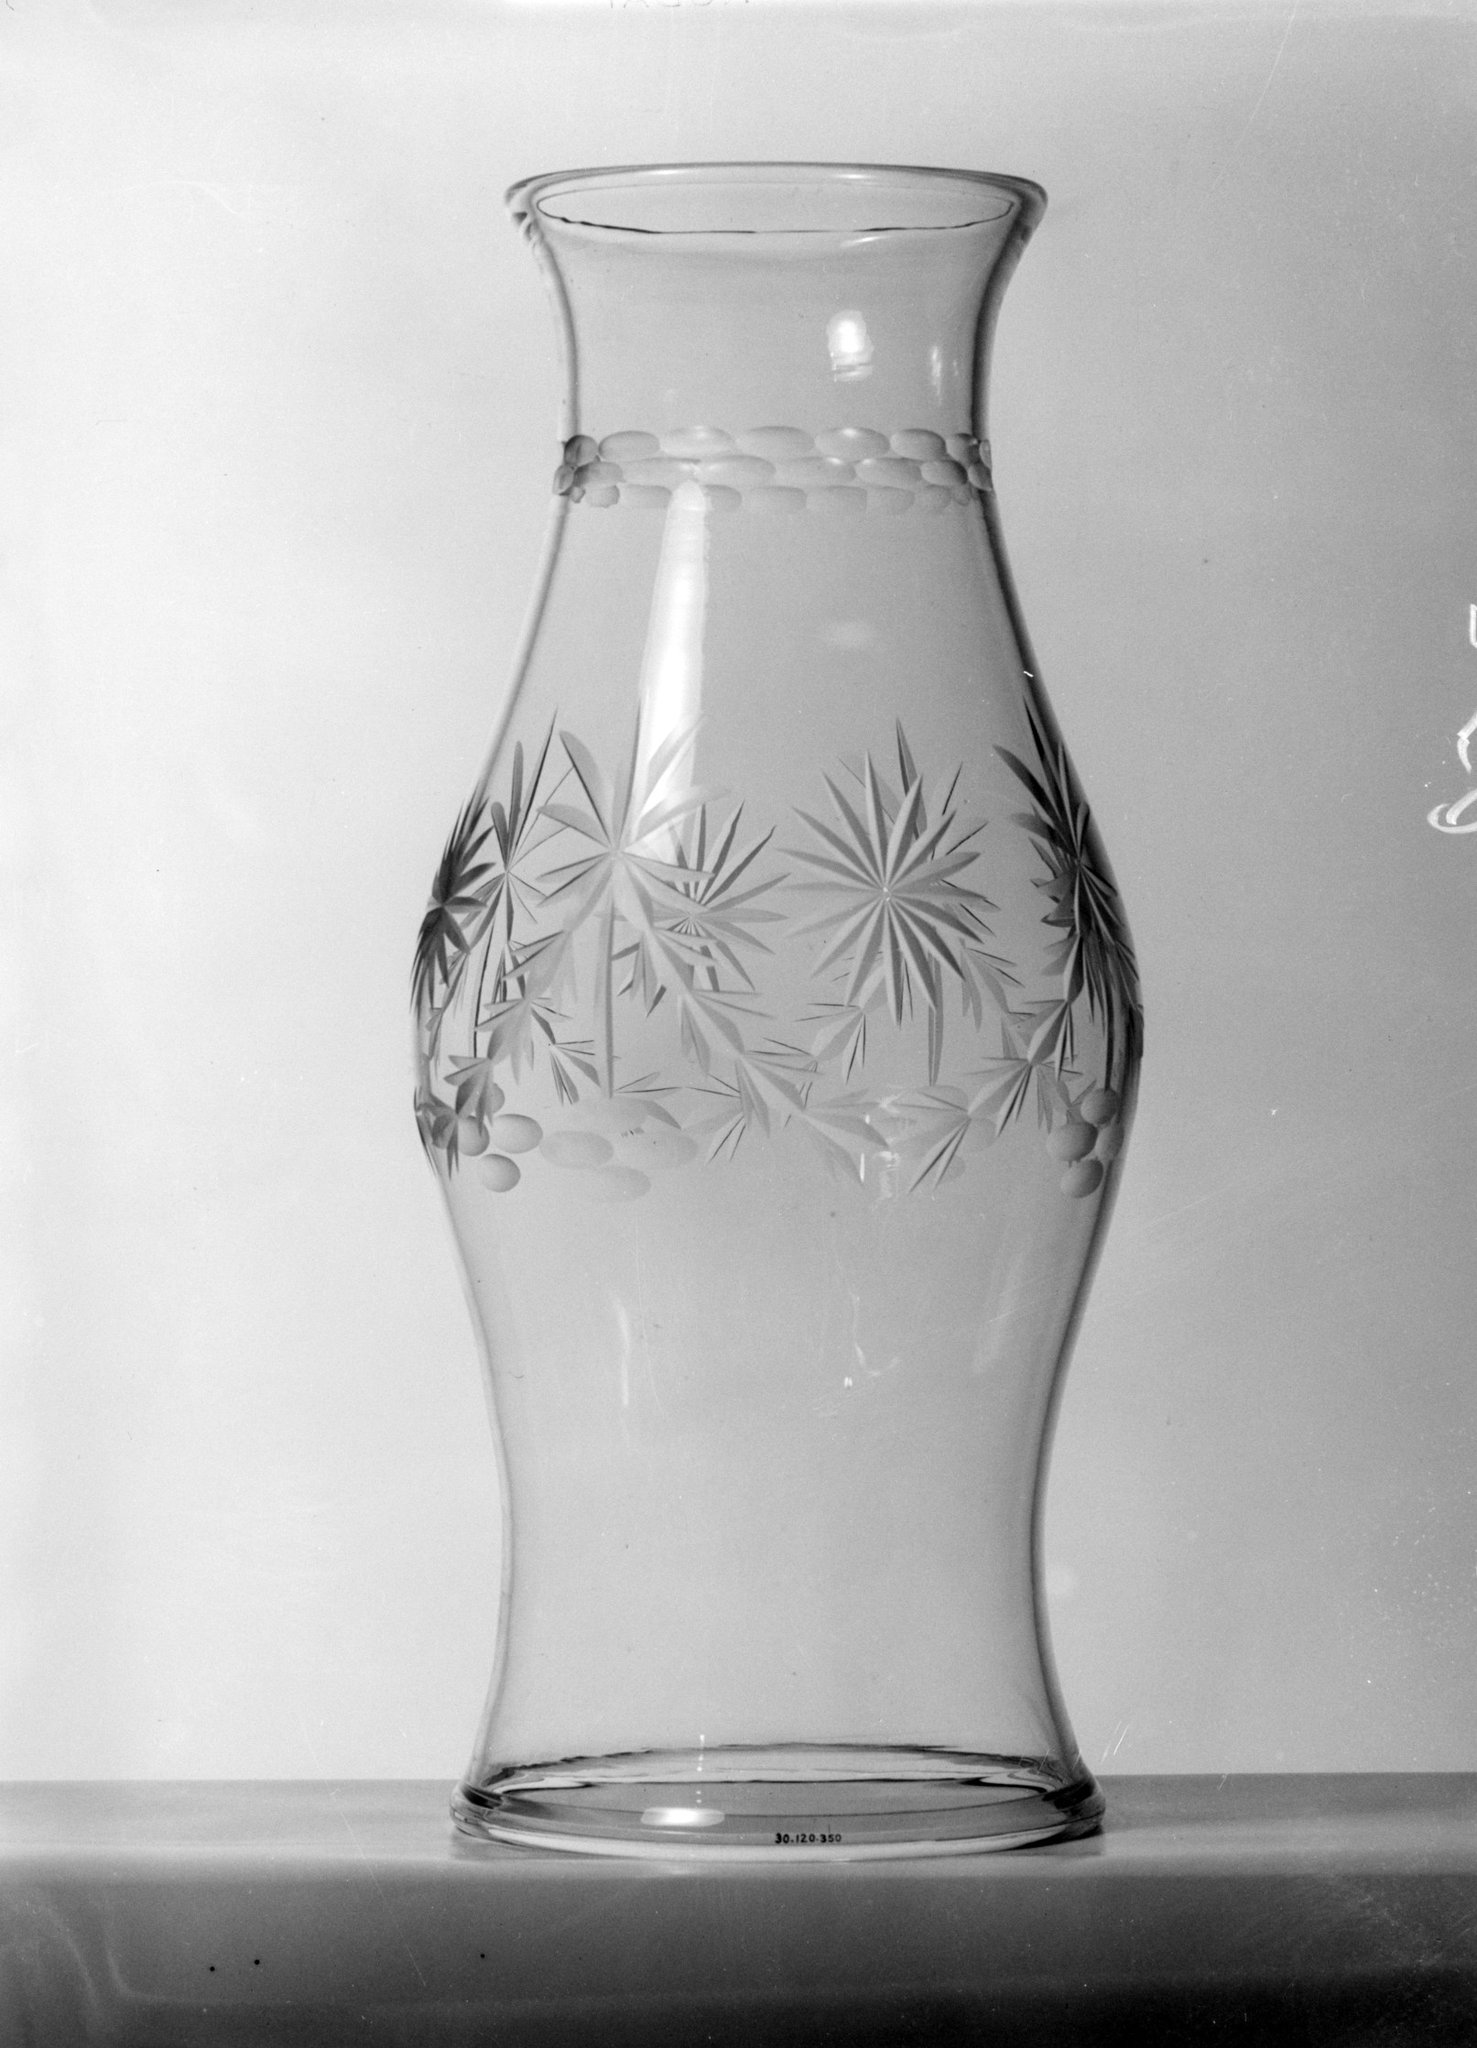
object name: hurricane shade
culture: british or irish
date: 1800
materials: glass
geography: ireland